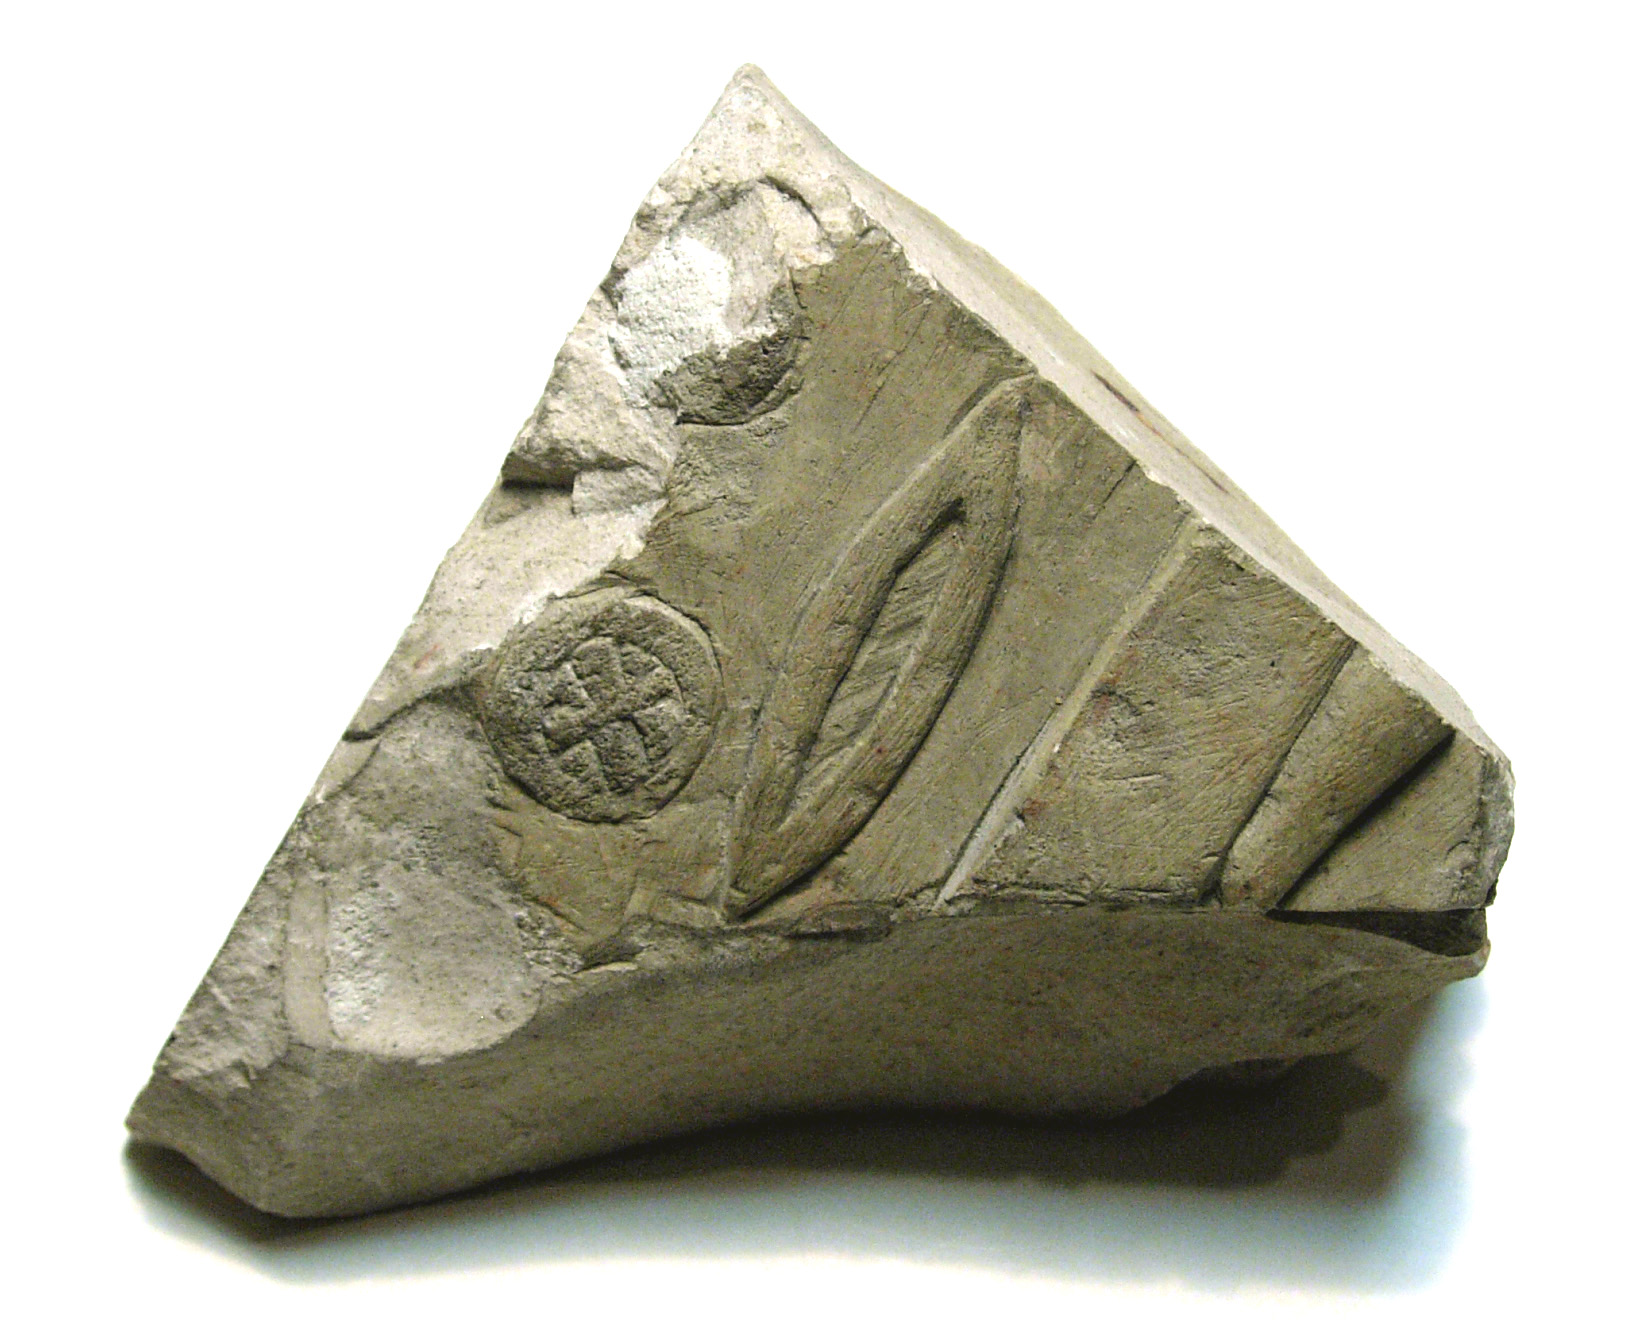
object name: relief, tomb of nespekashuty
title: Raised relief fragment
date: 664-610 BCE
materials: limestone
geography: egypt